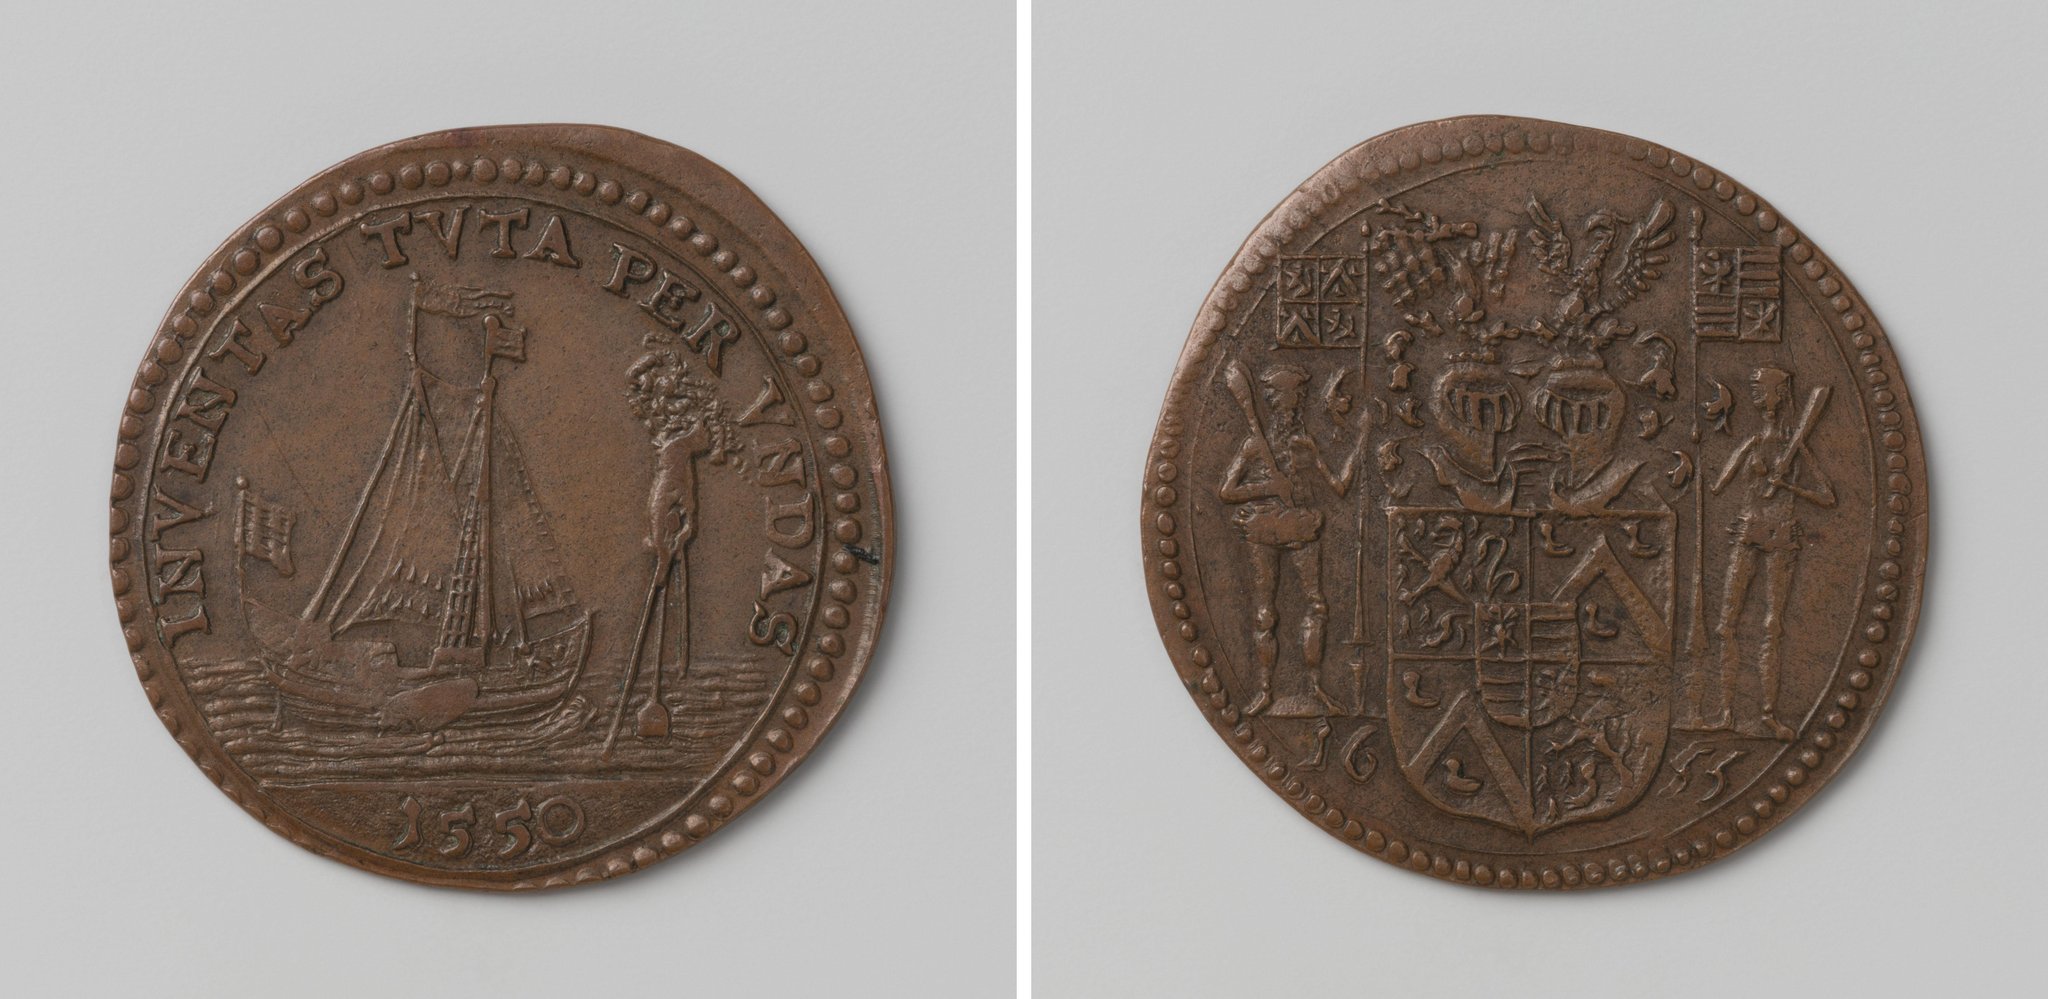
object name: jeton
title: Honderdvijfde verjaardag van het begin van de werkzaamheden aan de Brusselse vaart, rekenpenning geslagen ter ere van Charles de Locquenghien, negenendertigste intendant van de vaart van Brussel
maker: Anonymous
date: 1601-1655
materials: copper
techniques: striking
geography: brussels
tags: charles de locquenghien, willebroekse vaart